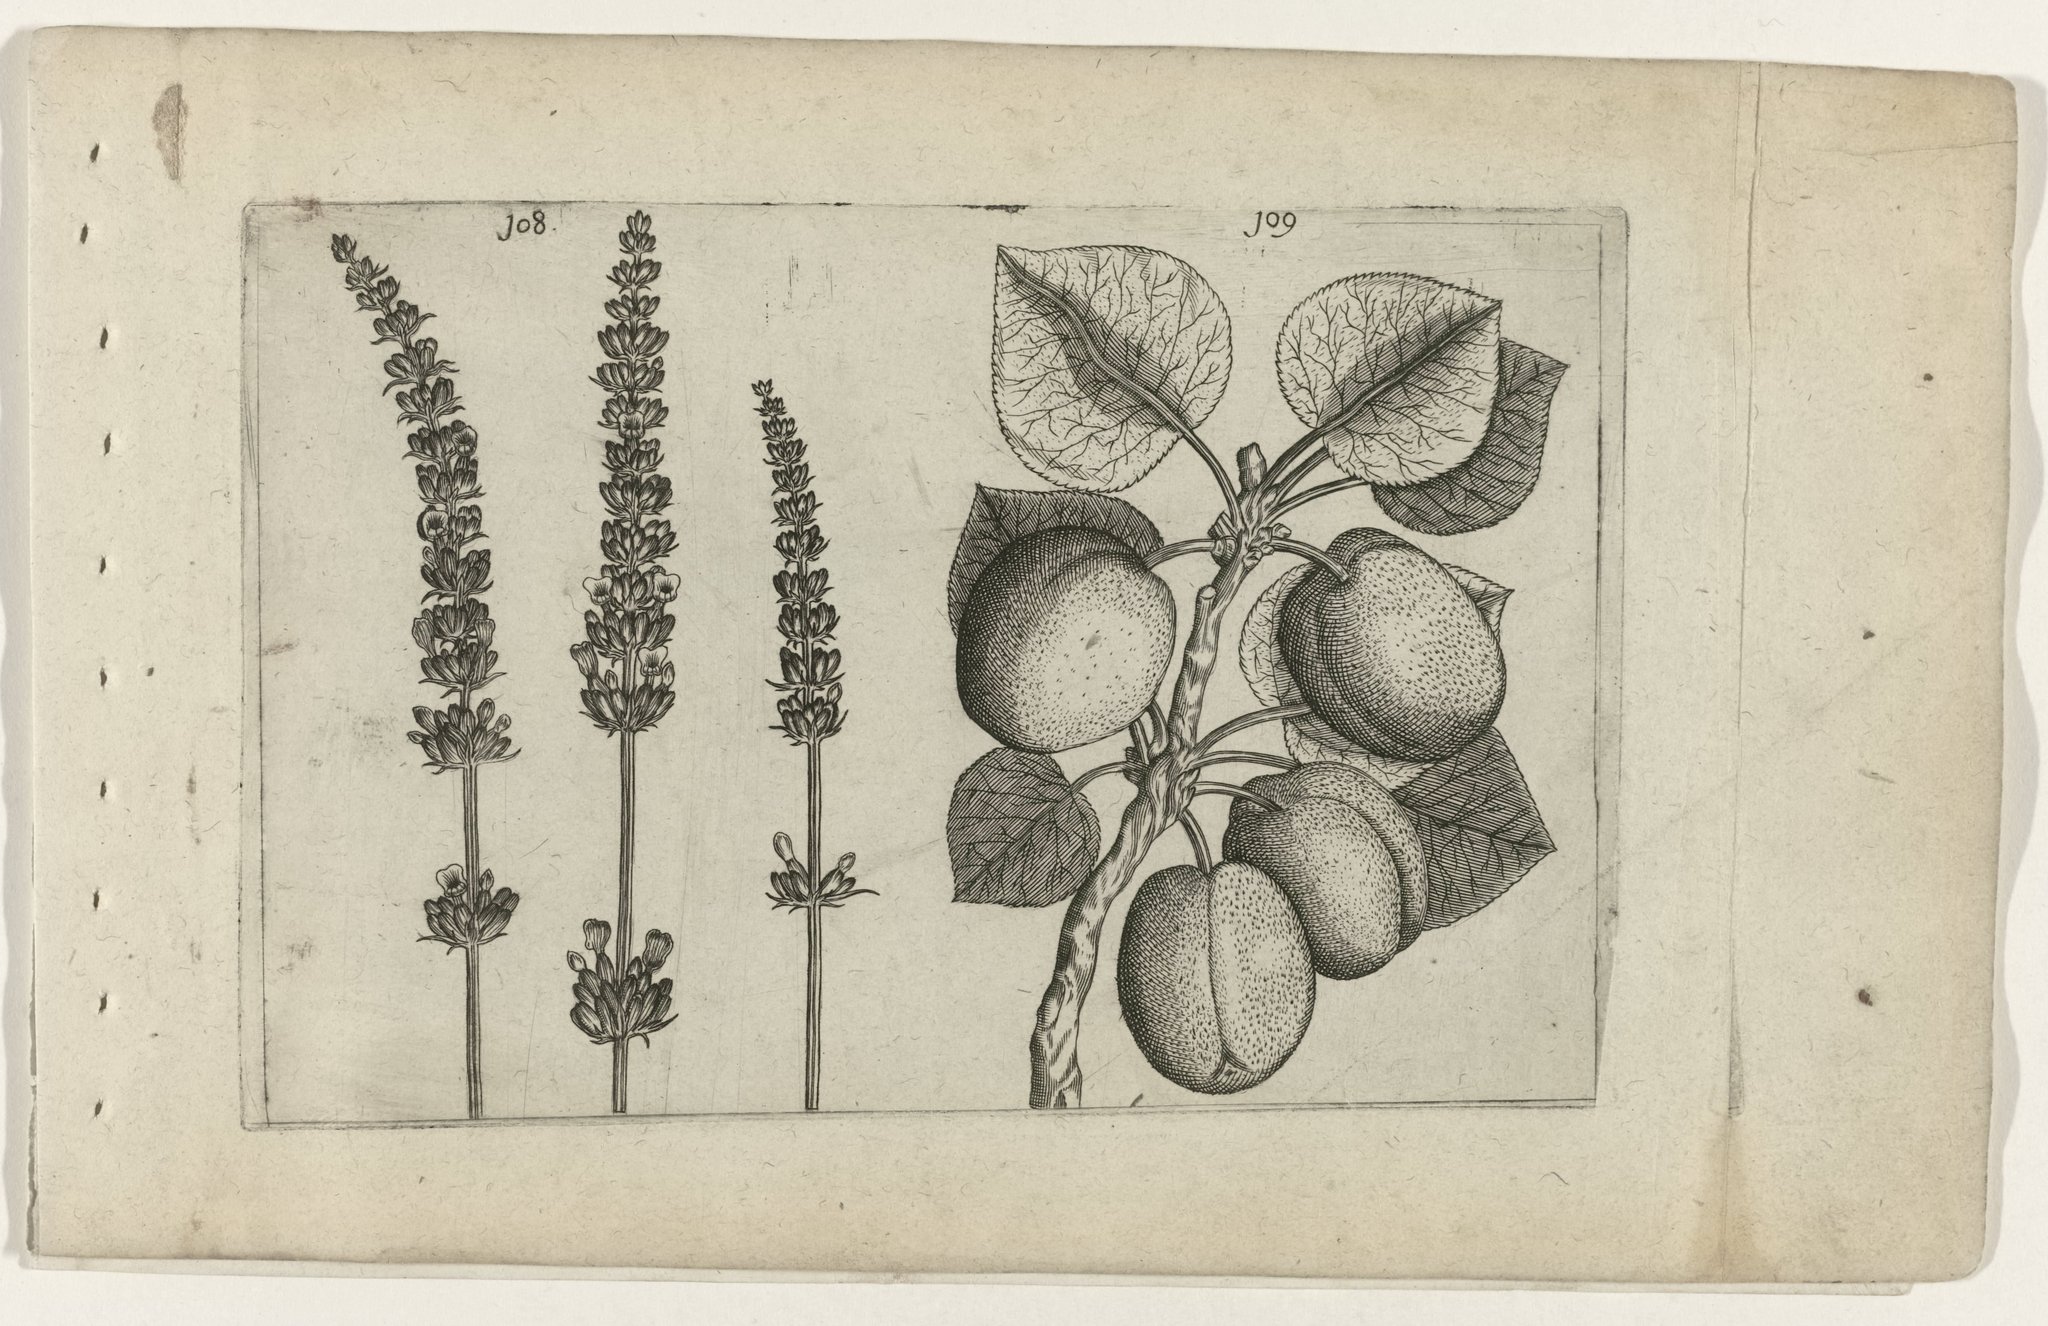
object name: print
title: Cognoscite lilia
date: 1600-1604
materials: paper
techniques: engraving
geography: cologne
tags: flowers: lavender, fruits: apricot, botany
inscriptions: collector's mark: Lugt 2228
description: De prenten RP-P-2012-24-1 t/m 61 waren oorspronkelijk als serie samengebonden. De naaigaten op de bladen zijn nog zichtbaar. Het betreft de reeks getiteld: Cognoscite lilia, bestaande uit een titelprent en 60 gravures met 119 genummerde weergaven van planten, bloemen en vruchten, versierd met rinceaux en kleine voorstellingen van dieren. Het gaat om proefdrukken van deze reeks gravures, voor de opschriften en, deels, voor de nummering. Op enkele prenten zijn de nummers met de hand aangebracht. Op de titelprent ontbreekt nog het adres van Crispijn de Passe en Hans Woutneel. De titel is hoogstwaarschijnlijk gegraveerd door Matthias Quad. Deze werkte voor De Passe in Keulen tot 1604. De reeks moet in dit jaar of daarvoor tot stand zijn gebracht. In ieder geval voor 1608, aangezien de uitgever Hans Woutneel in of voor dat jaar overleed. In ieder geval voor 1608, aangezien de uitgever Hans Woutneel in of voor dat jaar overleed. De gravures worden door Ilja Veldman en Anthony Griffiths beschouwd als eigenhandig werk van Crispijn de Passe I. Een van de prenten uit de reeks ontbreekt (nr 21-22) en is vervangen door een ingekleurde afdruk uit een latere uitgave (RP-P-2012-24-61), die onder de titel Altera Pars is opgenomen in de Hortus Floridus, uitgegeven door Crispijn de Passe I en die verder bestaat uit platen van Crispijn de Passe II. De prenten afkomstig uit deze uitgave zijn op de verso voorzien van tekst in boekdruk. De vervangende prent maakte geen deel uit van de gebonden serie aangezien dit blad als enige geen naaigaten heeft. Een deel van de planten, bloemen en vruchten in de Cognoscite lilia gaat terug of is gebaseerd op een reeks aquarellen van Jacques LeMoyne uit circa 1580 en uit 1585, nu in het Victoria and Albert Museum en de British Museum (zie P. Hulton, Jacques LeMoyne, Londen 1977, dl 1, p. 156-162 en p. 165-173).